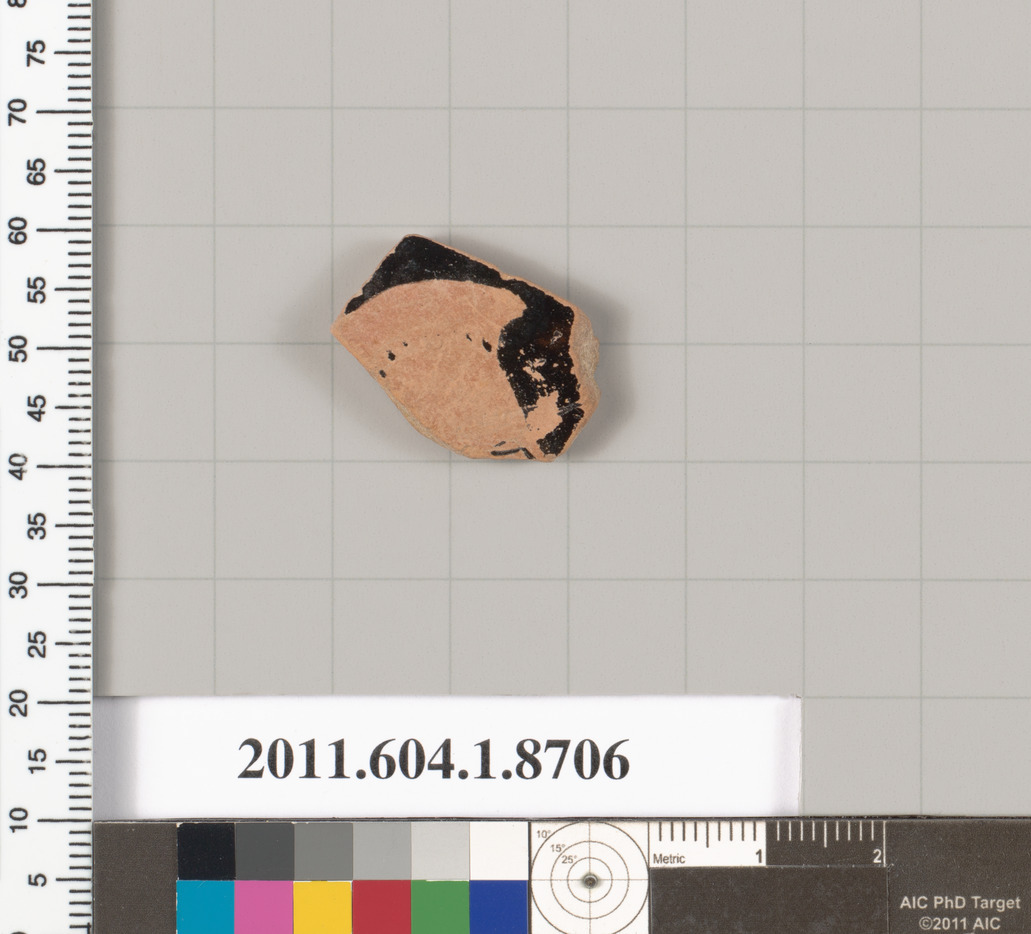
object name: kylix fragment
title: Terracotta fragment of a kylix (drinking cup)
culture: greek, attic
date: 500-480 BCE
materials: terracotta